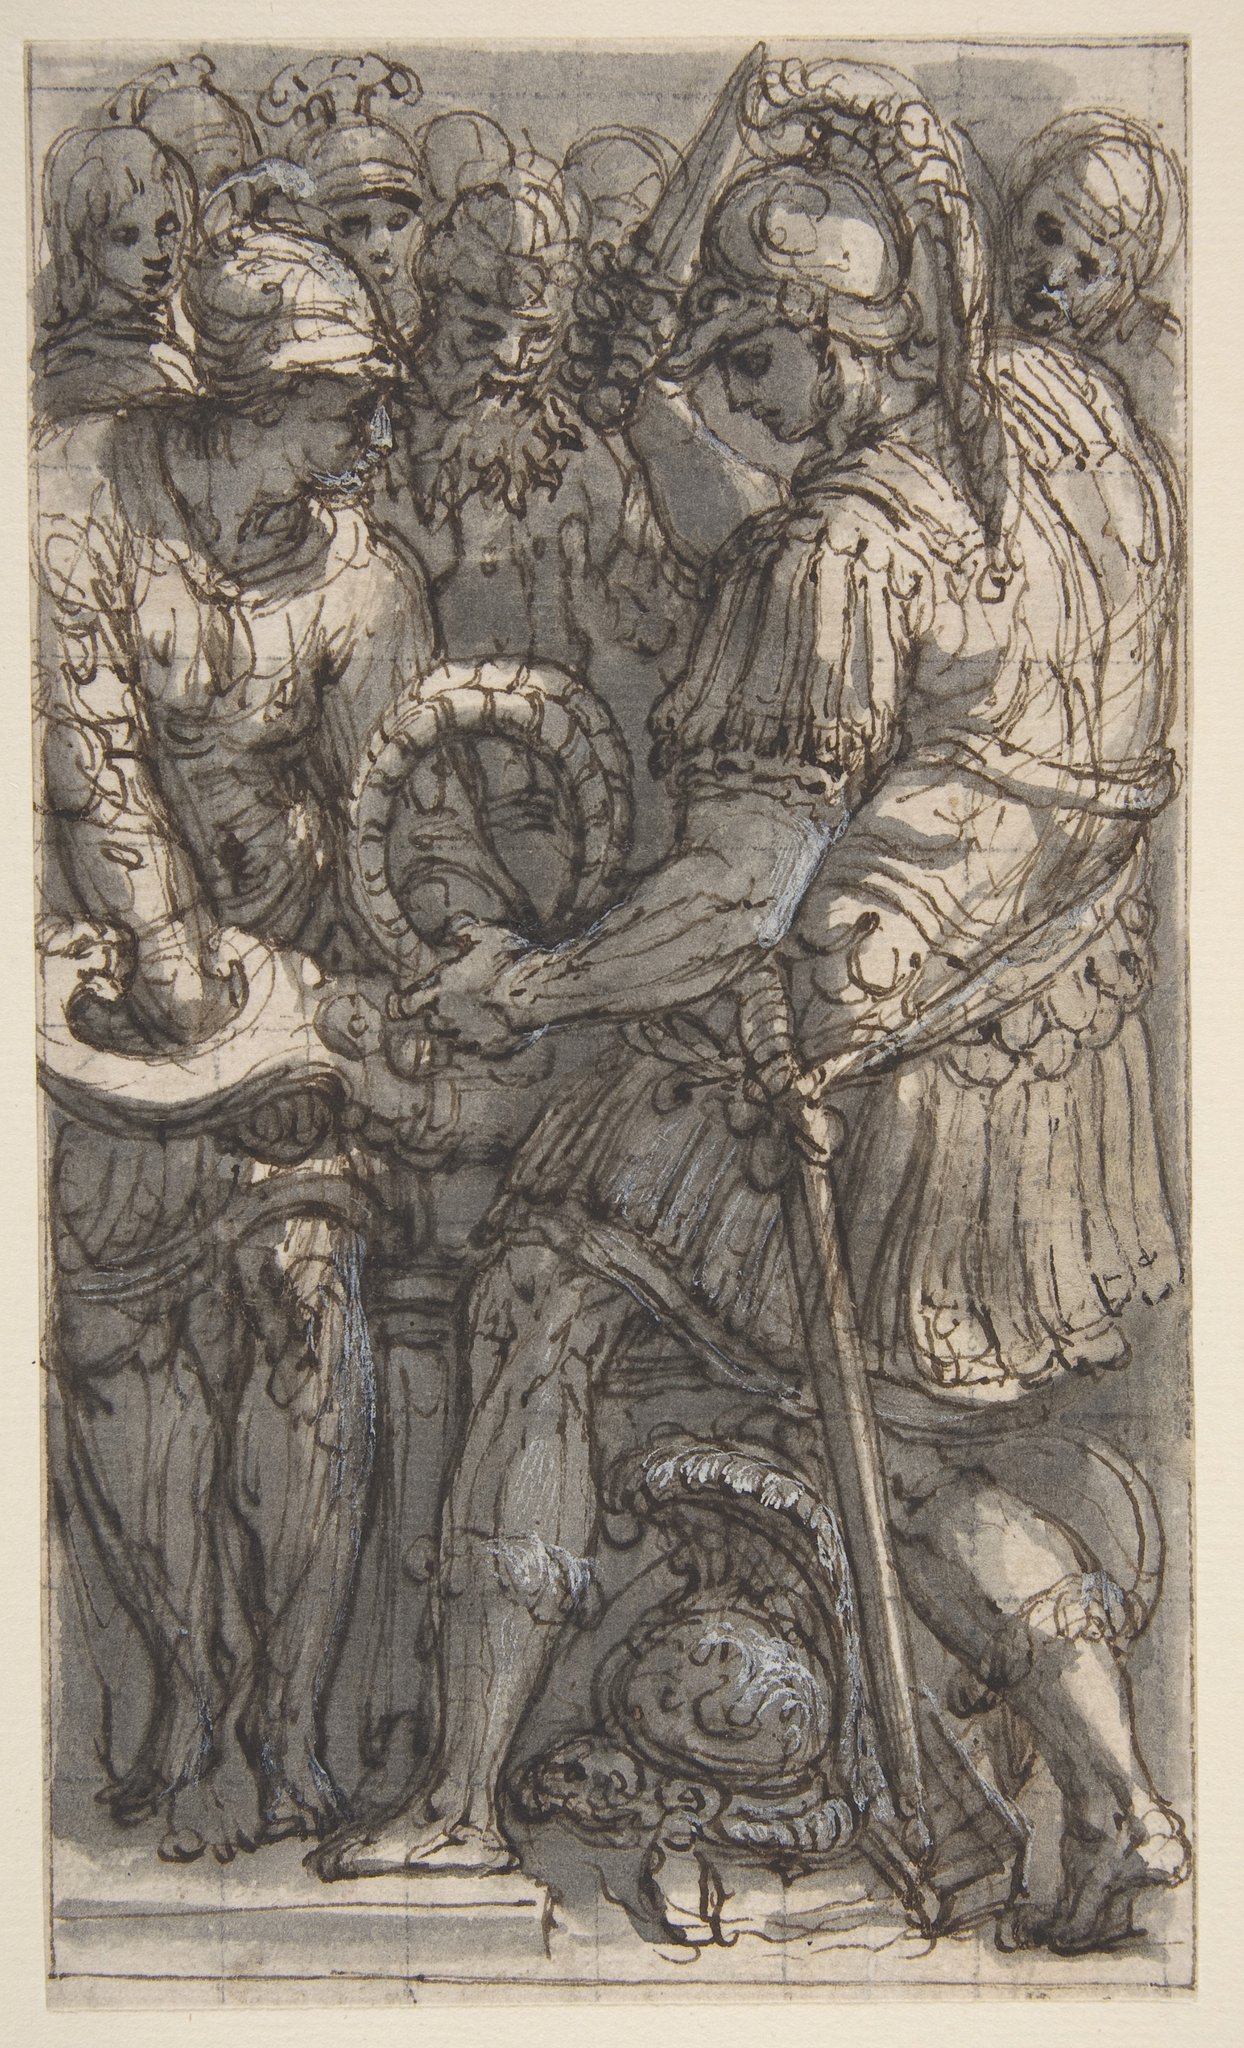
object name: drawing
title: Alexander Cutting the Gordian Knot, Study for a Fresco in the Castel Sant'Angelo, Rome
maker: perino del vaga (pietro buonaccorsi)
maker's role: artist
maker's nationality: italian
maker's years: 1501-1547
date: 1501-1547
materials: chalk, ink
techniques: brush, highlighting, pen, drawing, wash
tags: swords,alexander the great,men